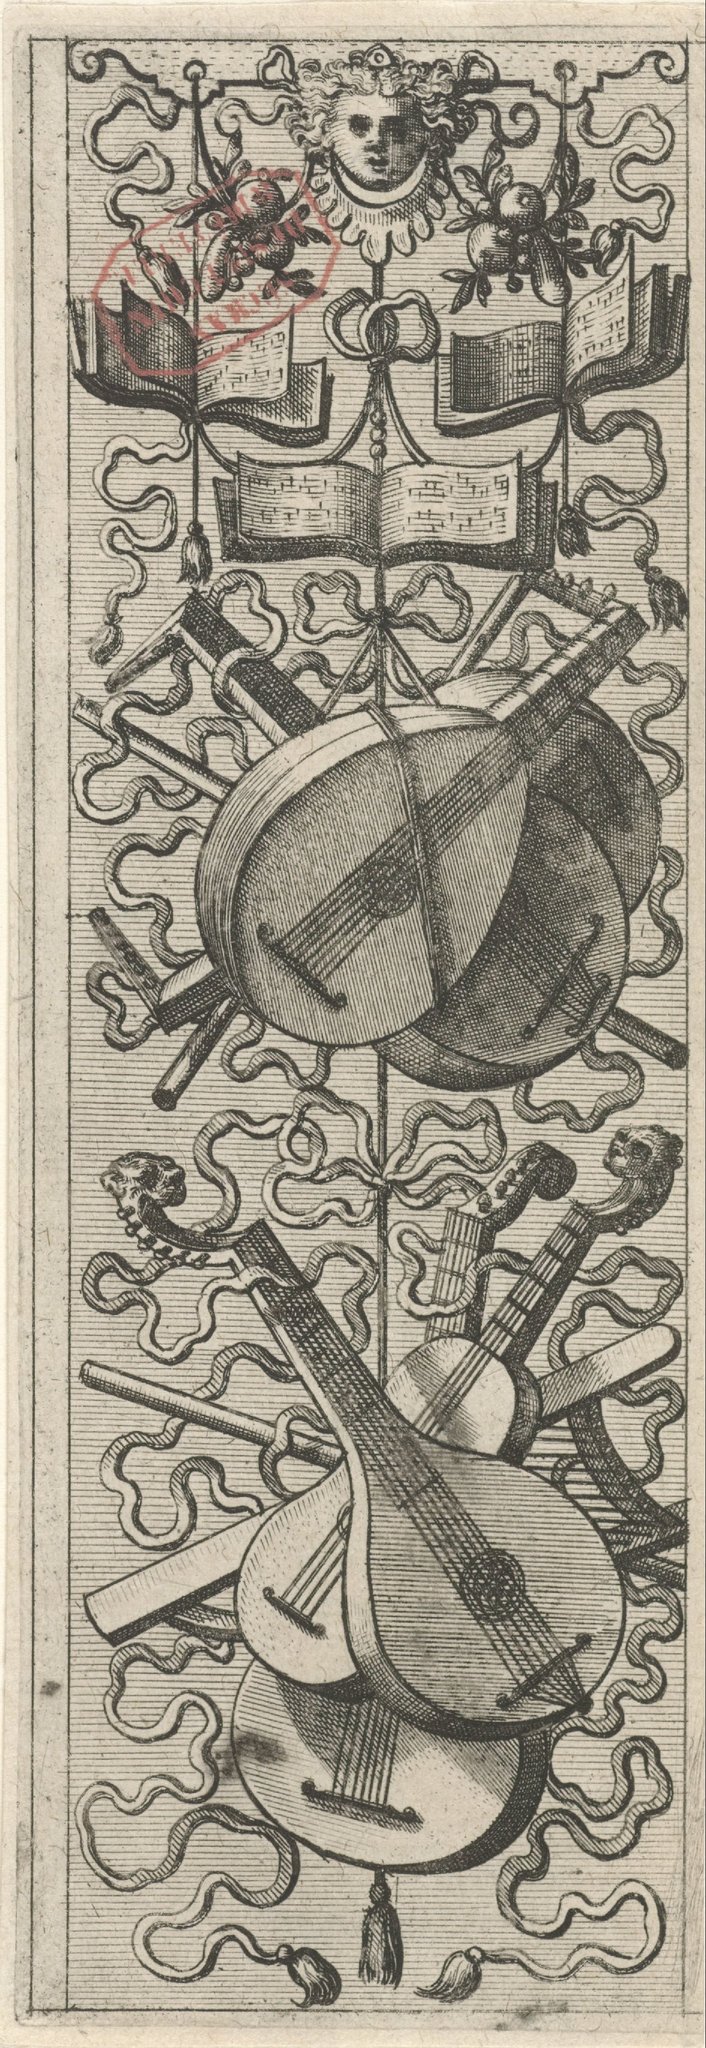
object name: ornament print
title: Panoplia sev armamentarium…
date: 1572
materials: paper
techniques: etching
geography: netherlands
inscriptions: collector's mark: Lugt 2275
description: Drie muziekboeken en snaarinstrumenten. Uit serie, bestaande uit een titelblad en 16 bladen.